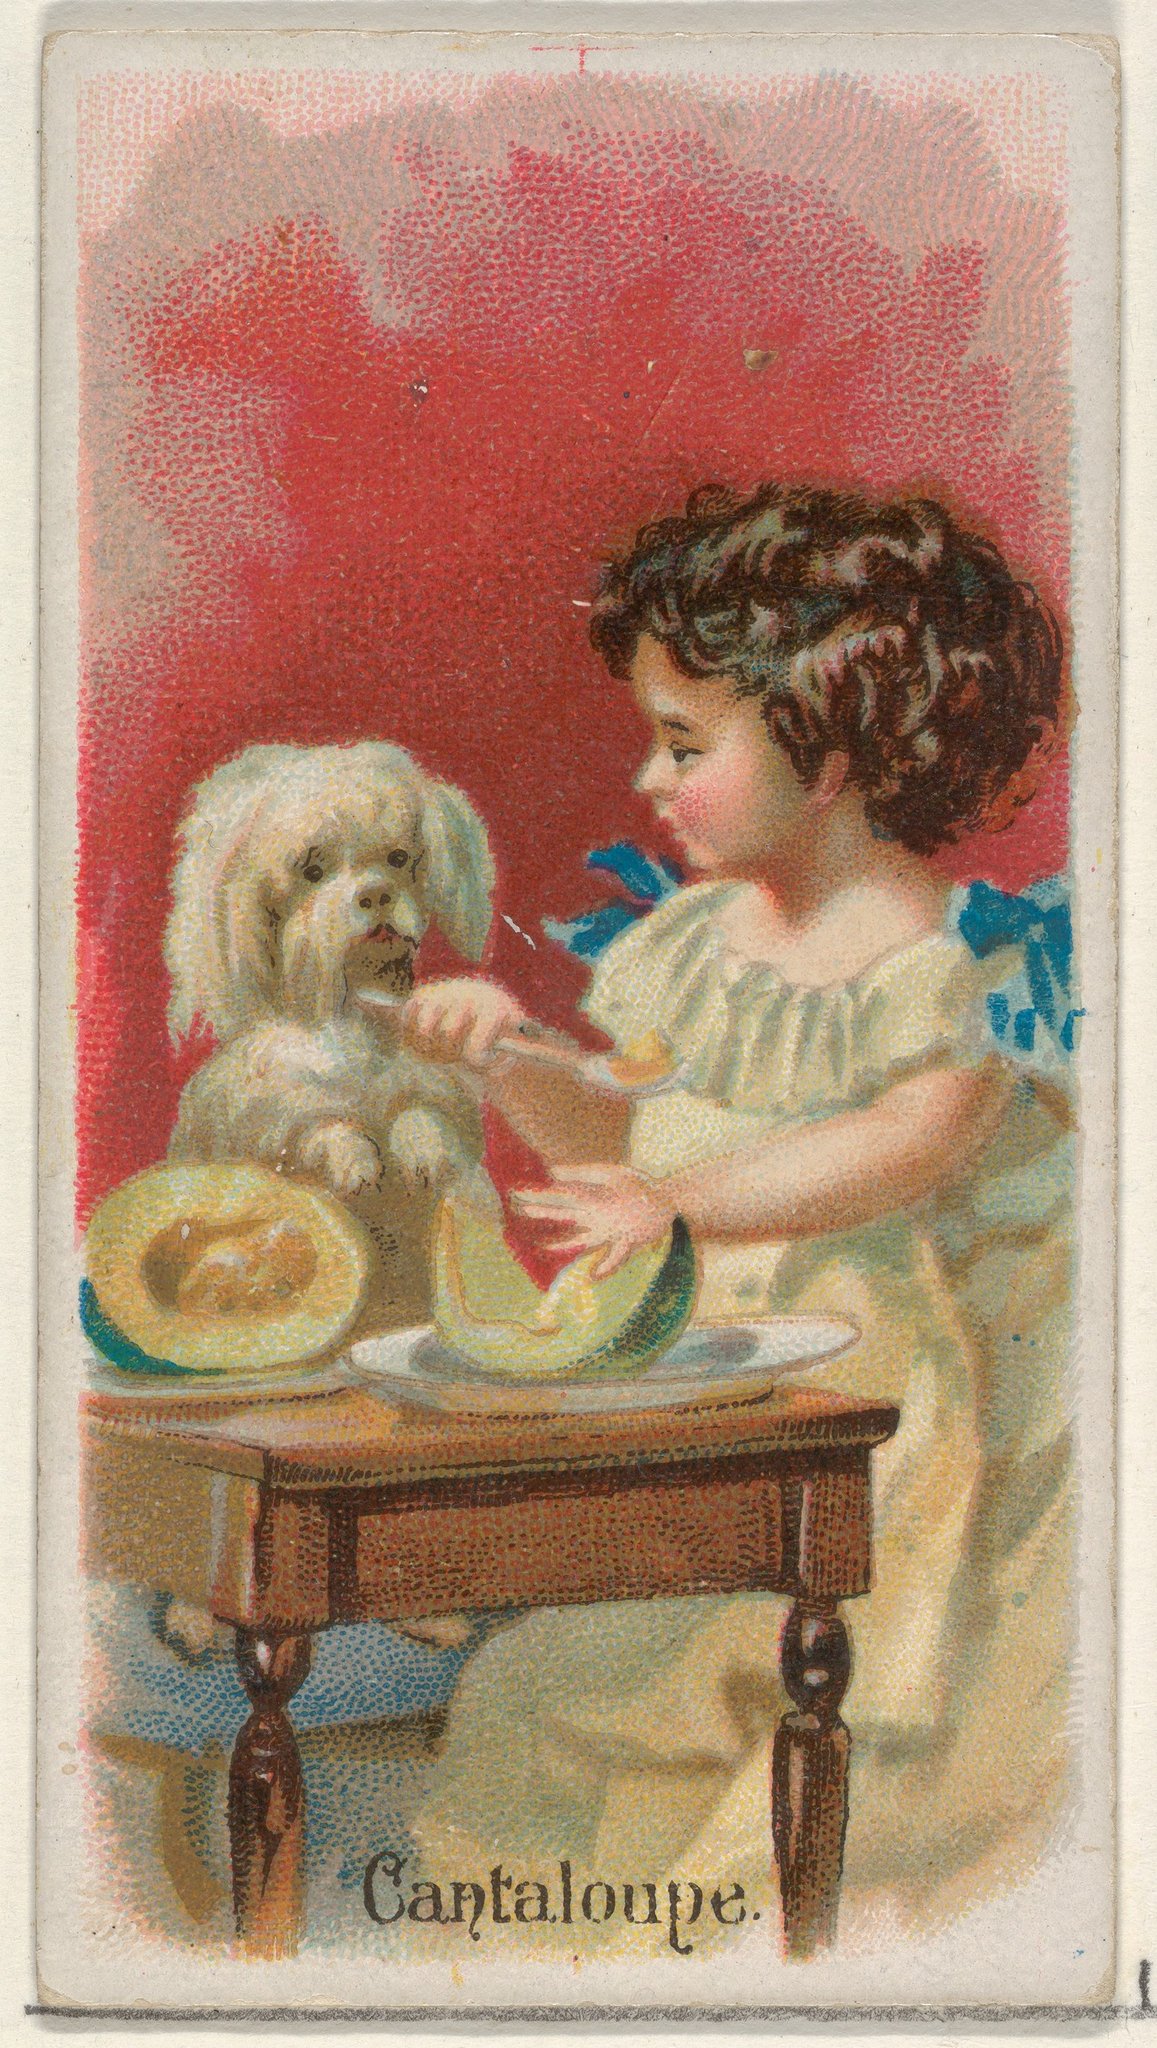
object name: print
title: Cantaloupe, from the Fruits series (N12) for Allen & Ginter Cigarettes Brands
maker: allen & ginter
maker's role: publisher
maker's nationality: american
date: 1891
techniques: color lithograph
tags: fruit,girls,dogs